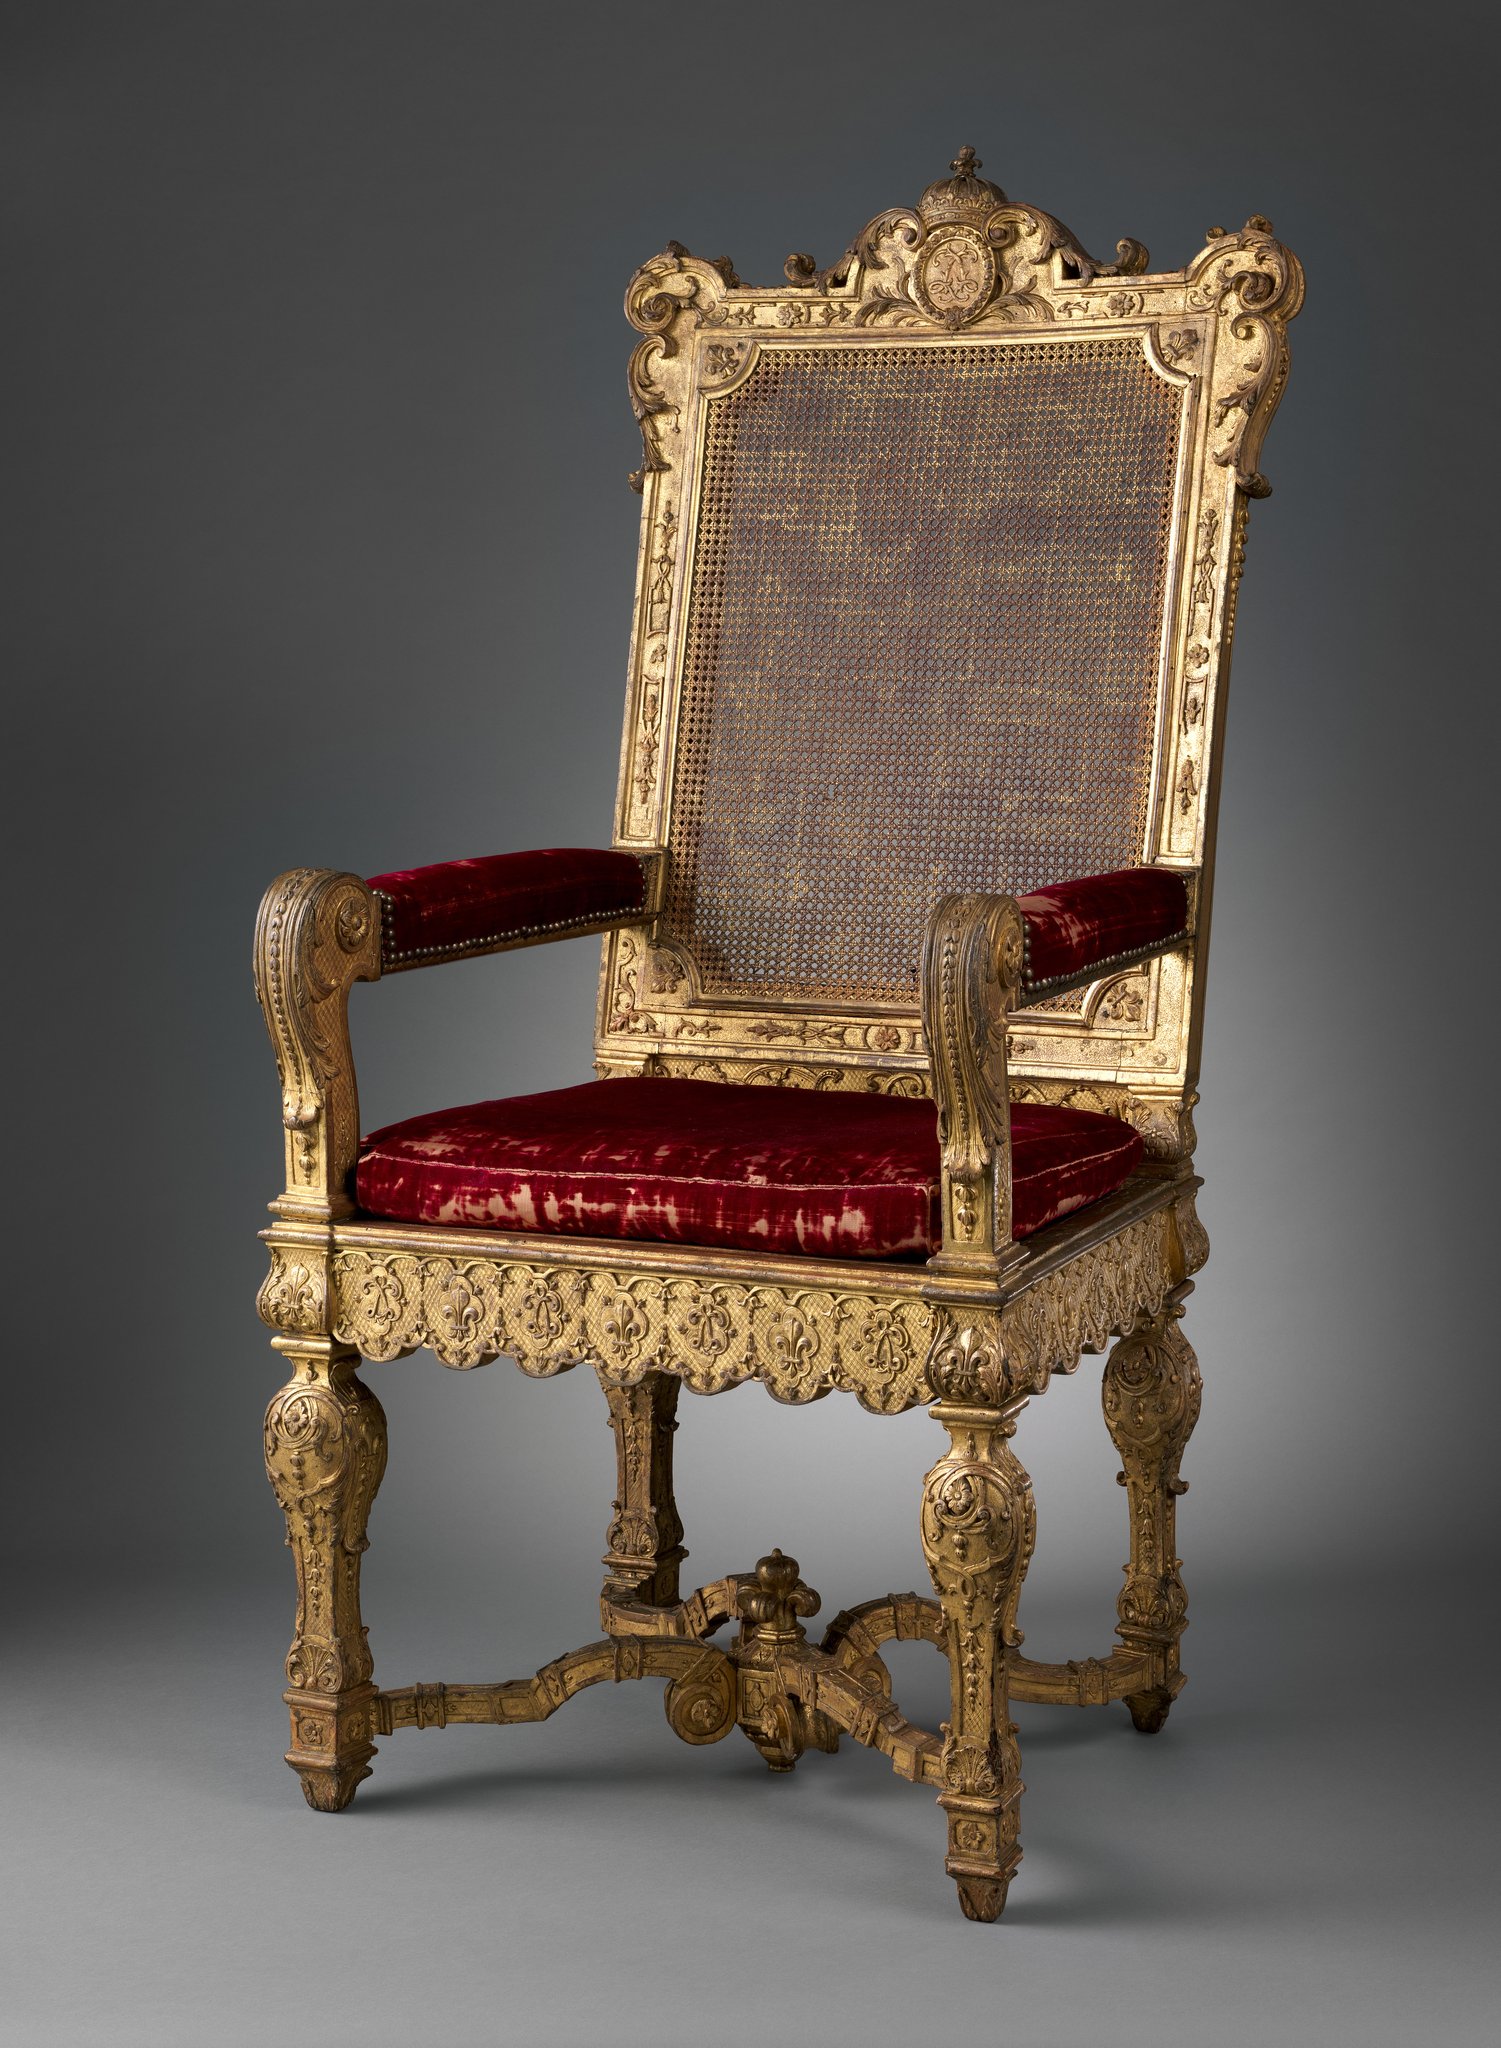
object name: armchair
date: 1700-1710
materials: velvet, wood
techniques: carving, gilding